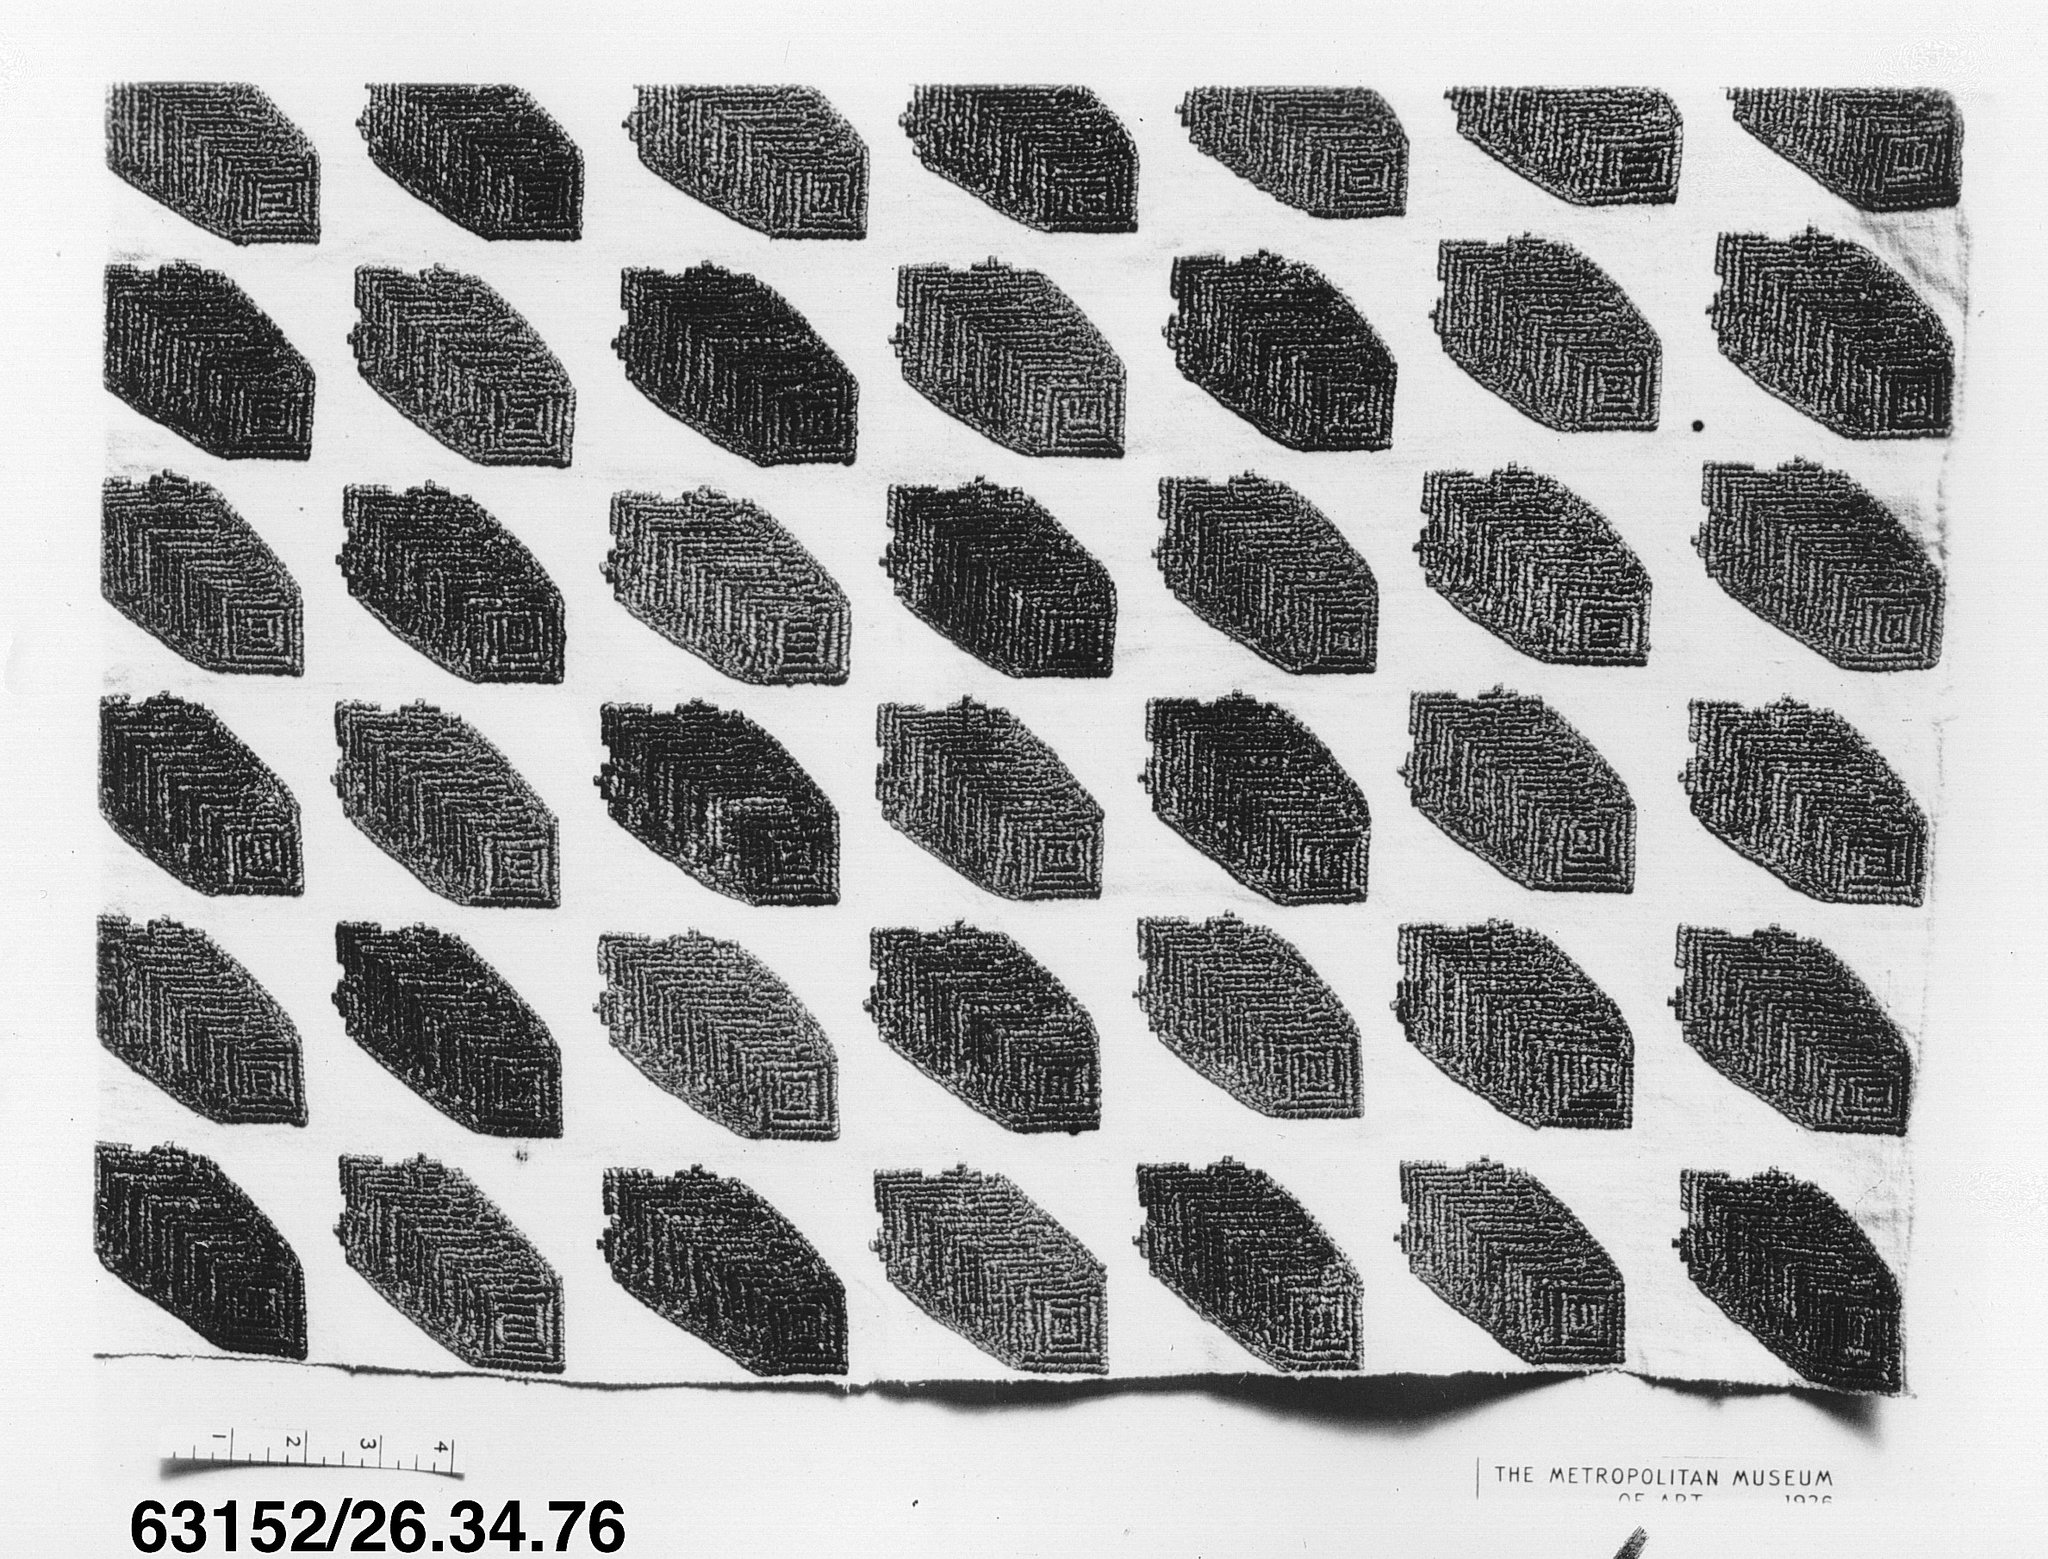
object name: bed curtain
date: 1701-1800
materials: linen, silk